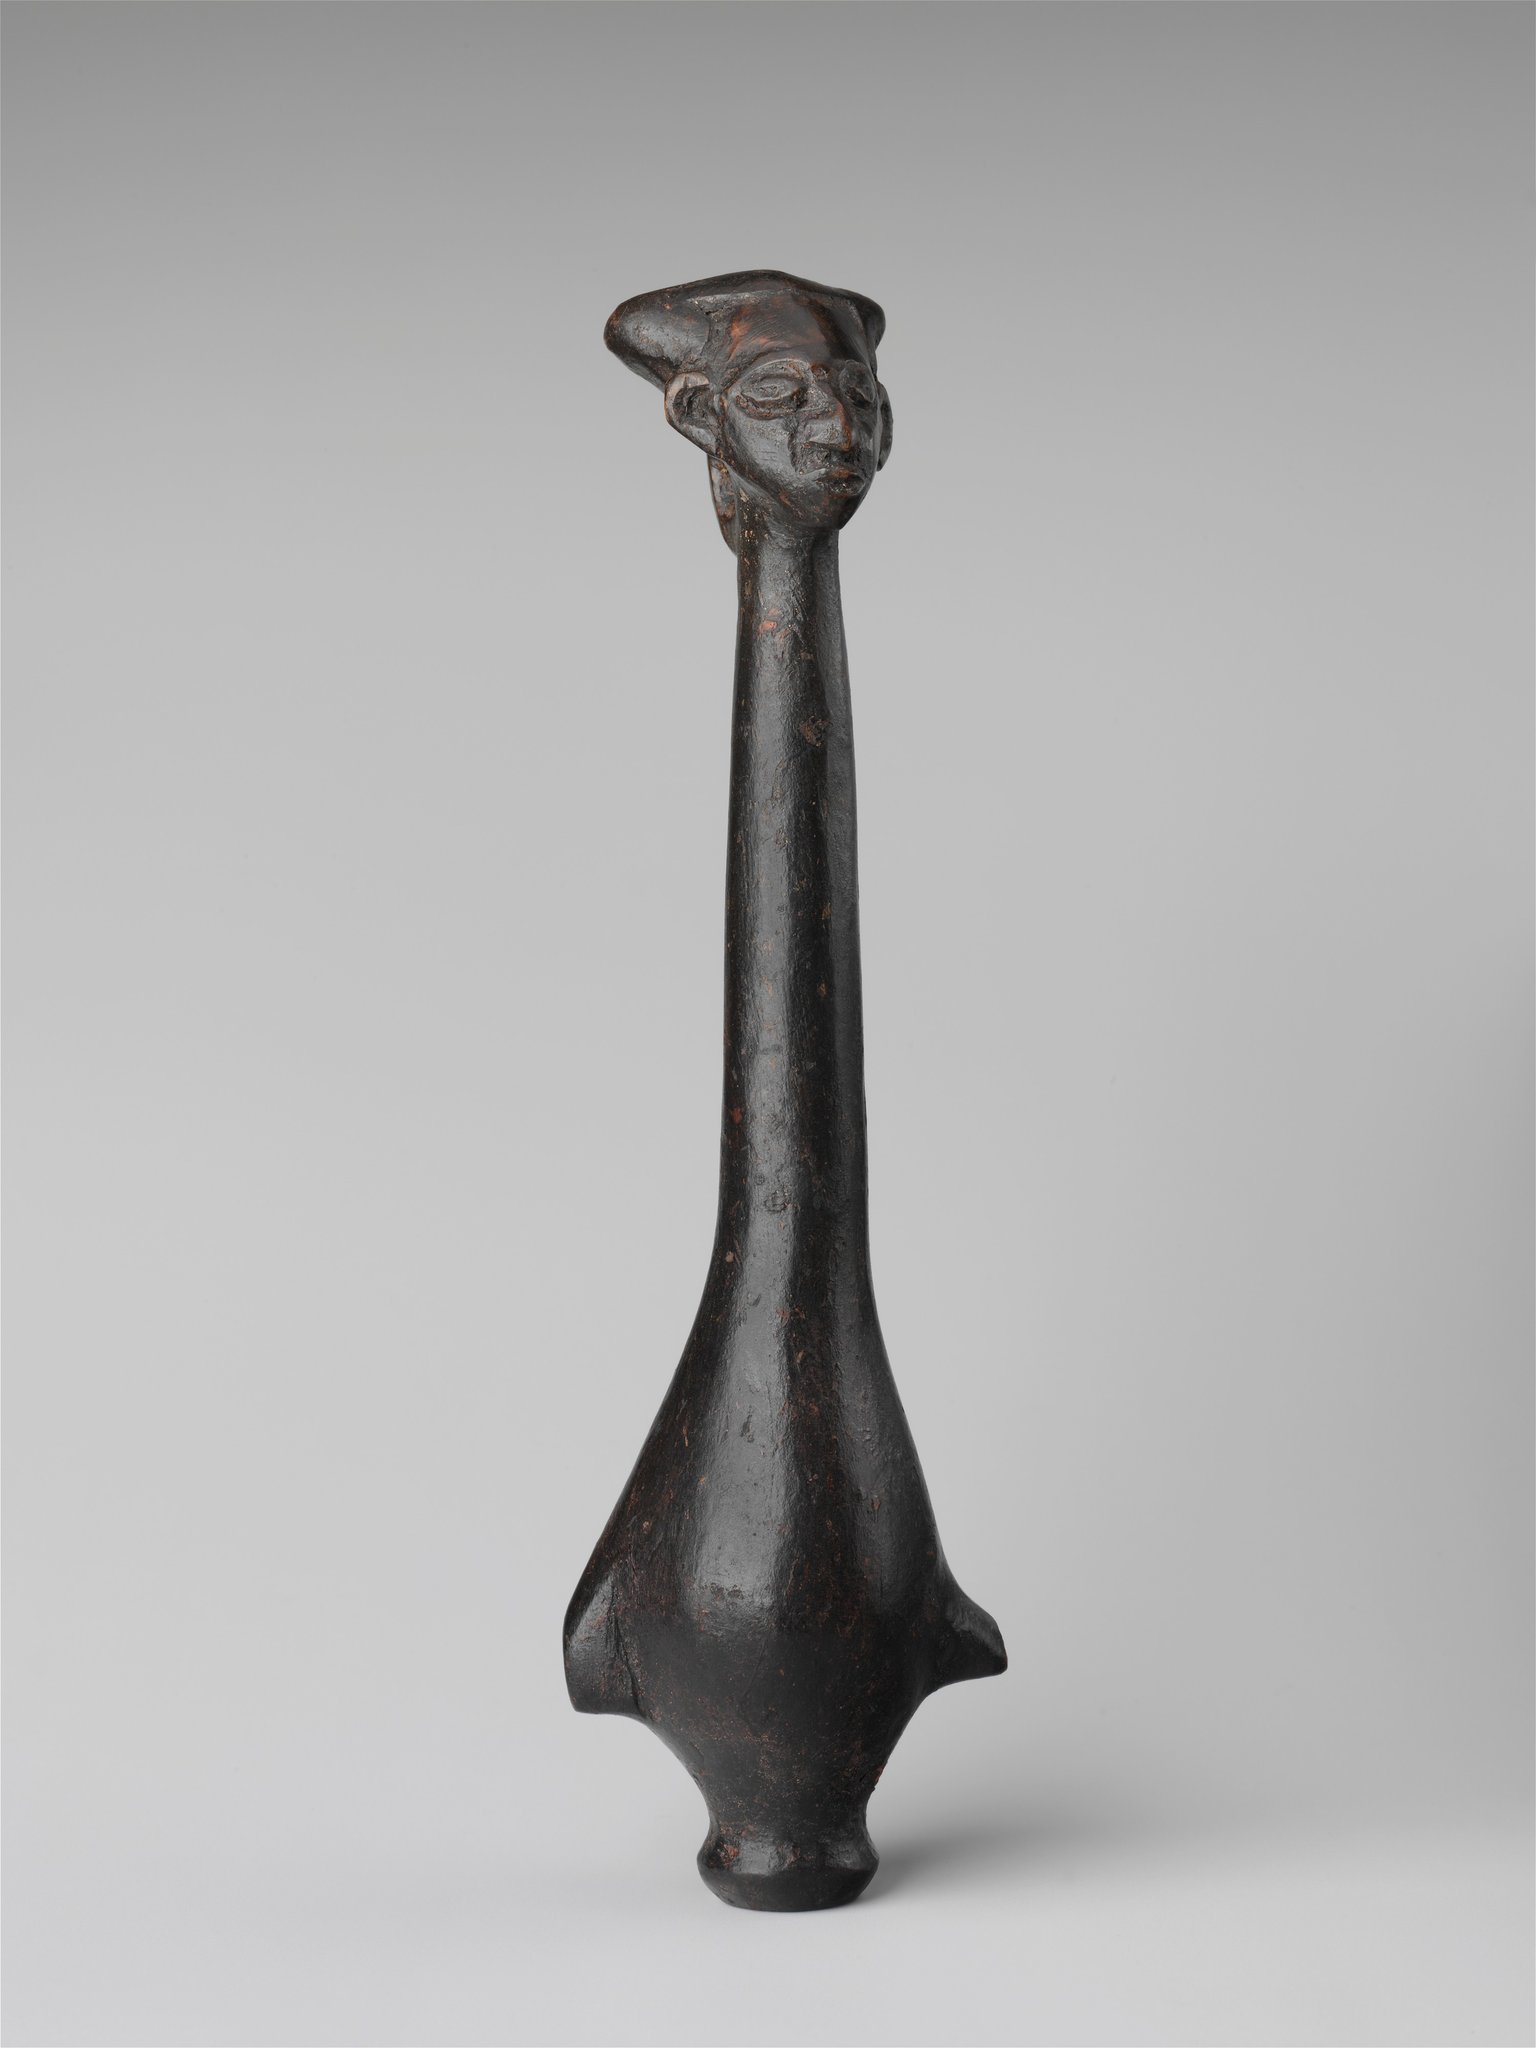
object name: whistle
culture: kuba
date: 1834-1866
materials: wood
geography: democratic republic of the congo